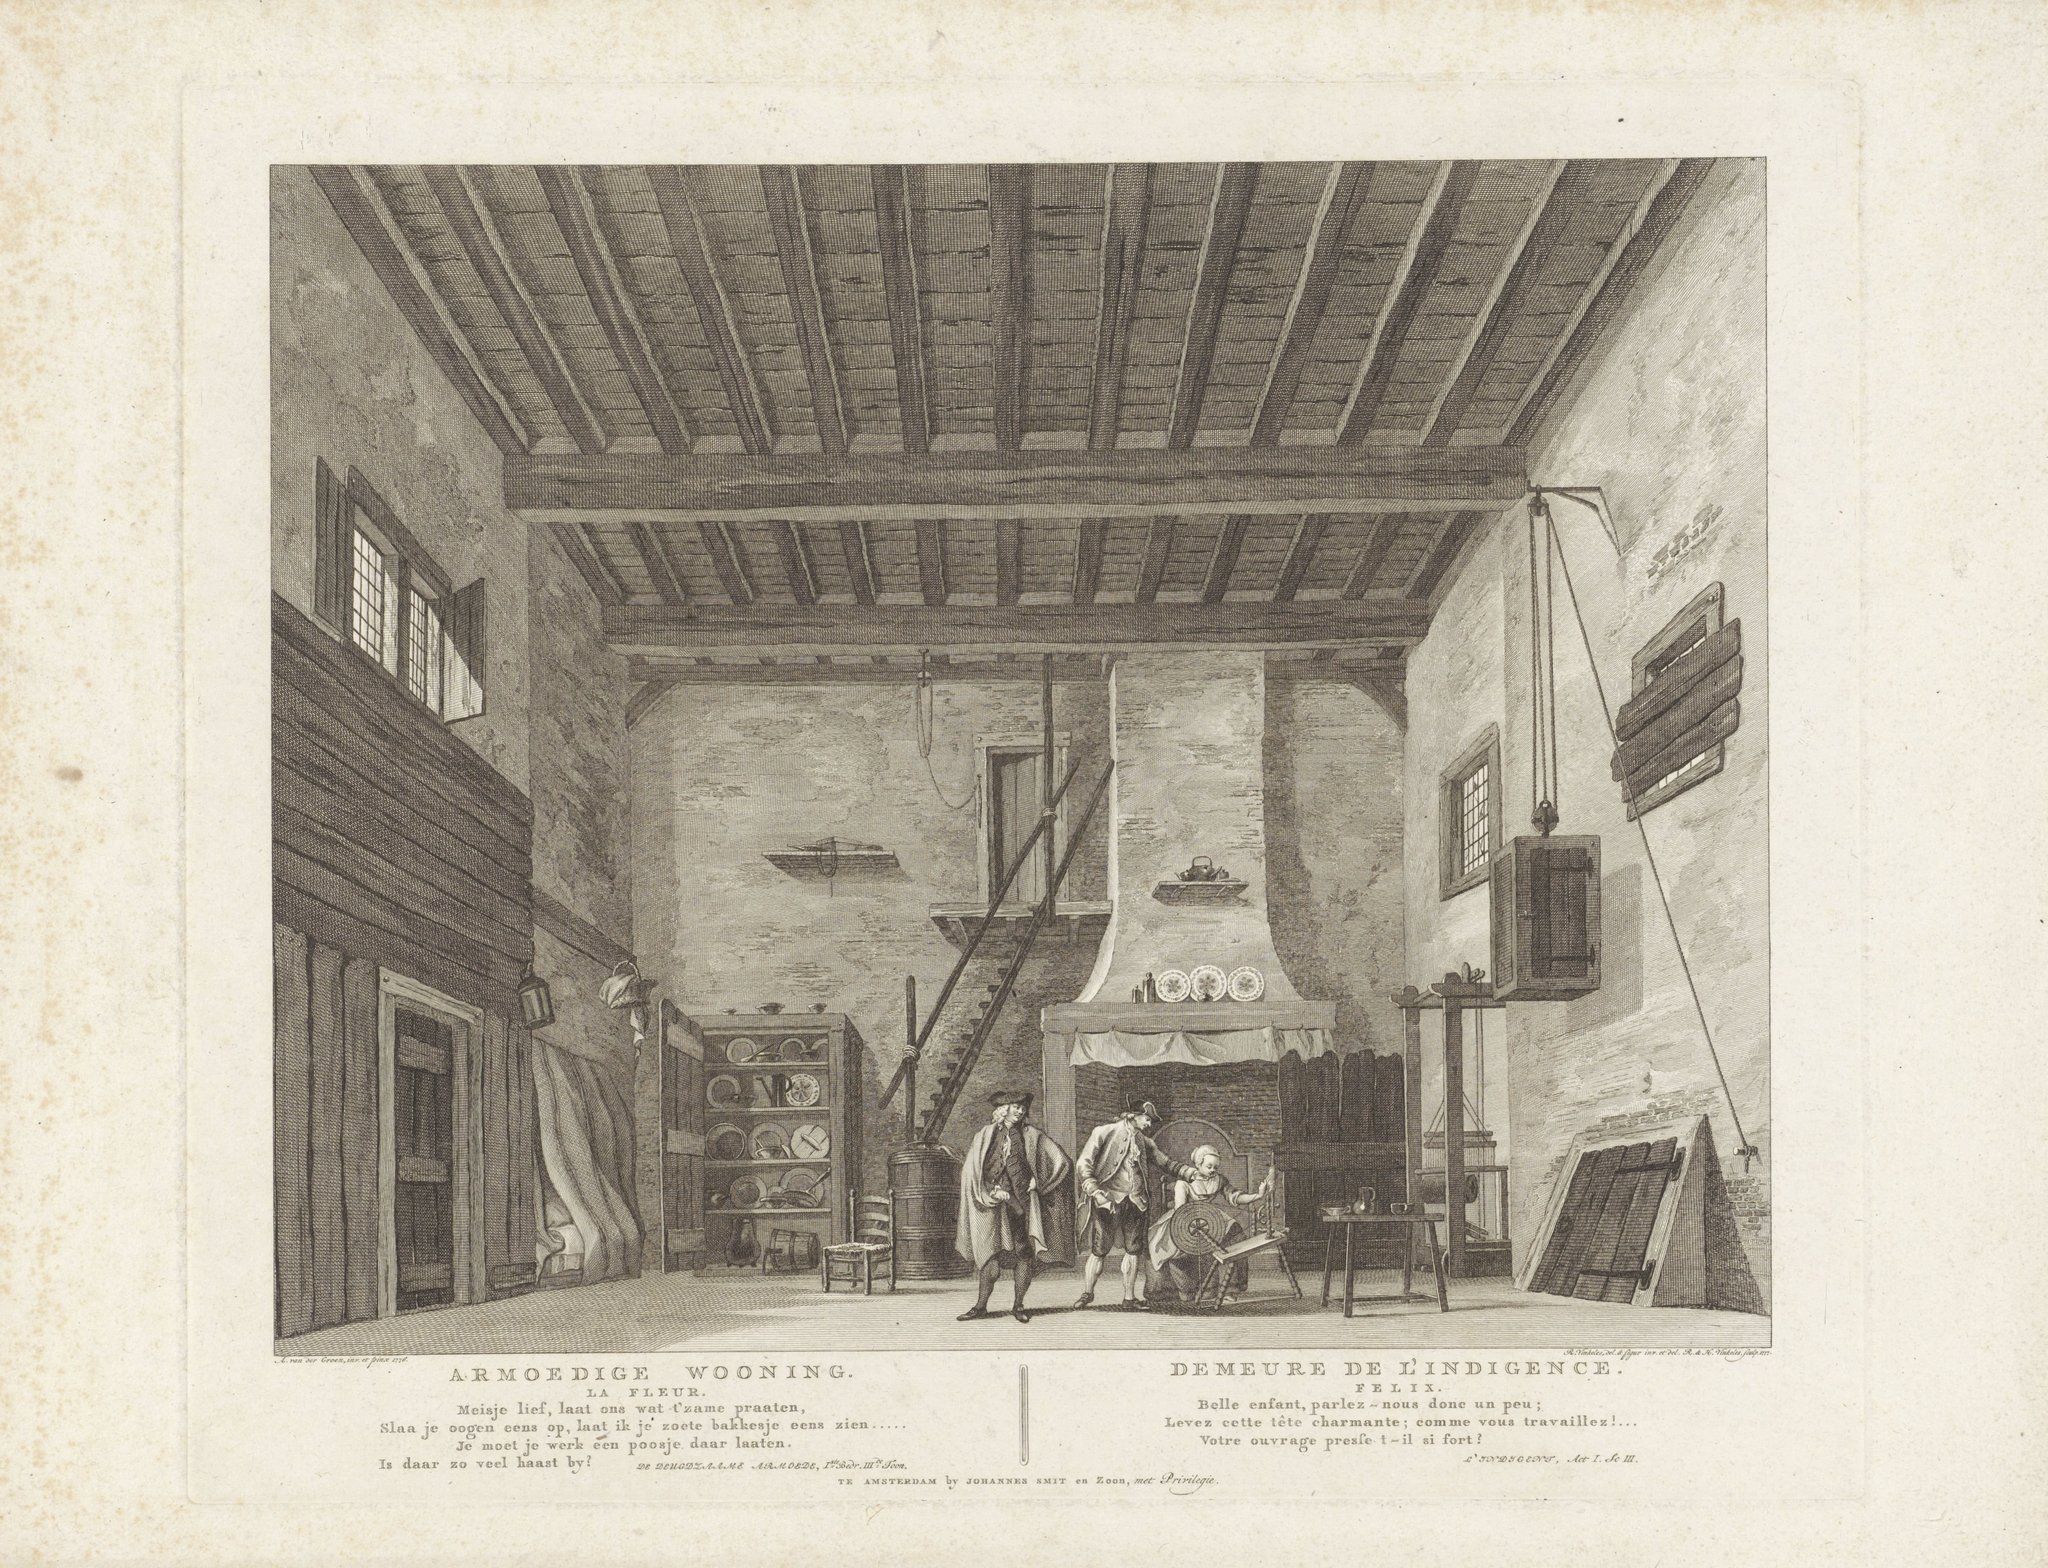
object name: print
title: Toneeldecors van de nieuwe Amsterdamse Schouwburg, 1775-1777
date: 1777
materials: paper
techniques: engraving, etching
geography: amsterdam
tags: politician, theatre, theatrical performance, stage design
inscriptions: collector's mark: Lugt 2228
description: Het coulissendecor Armoedige Wooning, met een scène uit: De Deugdzame Armoede. Onderdeel van een serie van zes toneeldecors van toneelstukken opgevoerd in de nieuwe Amsterdamse Schouwburg uit de jaren 1775-1777.